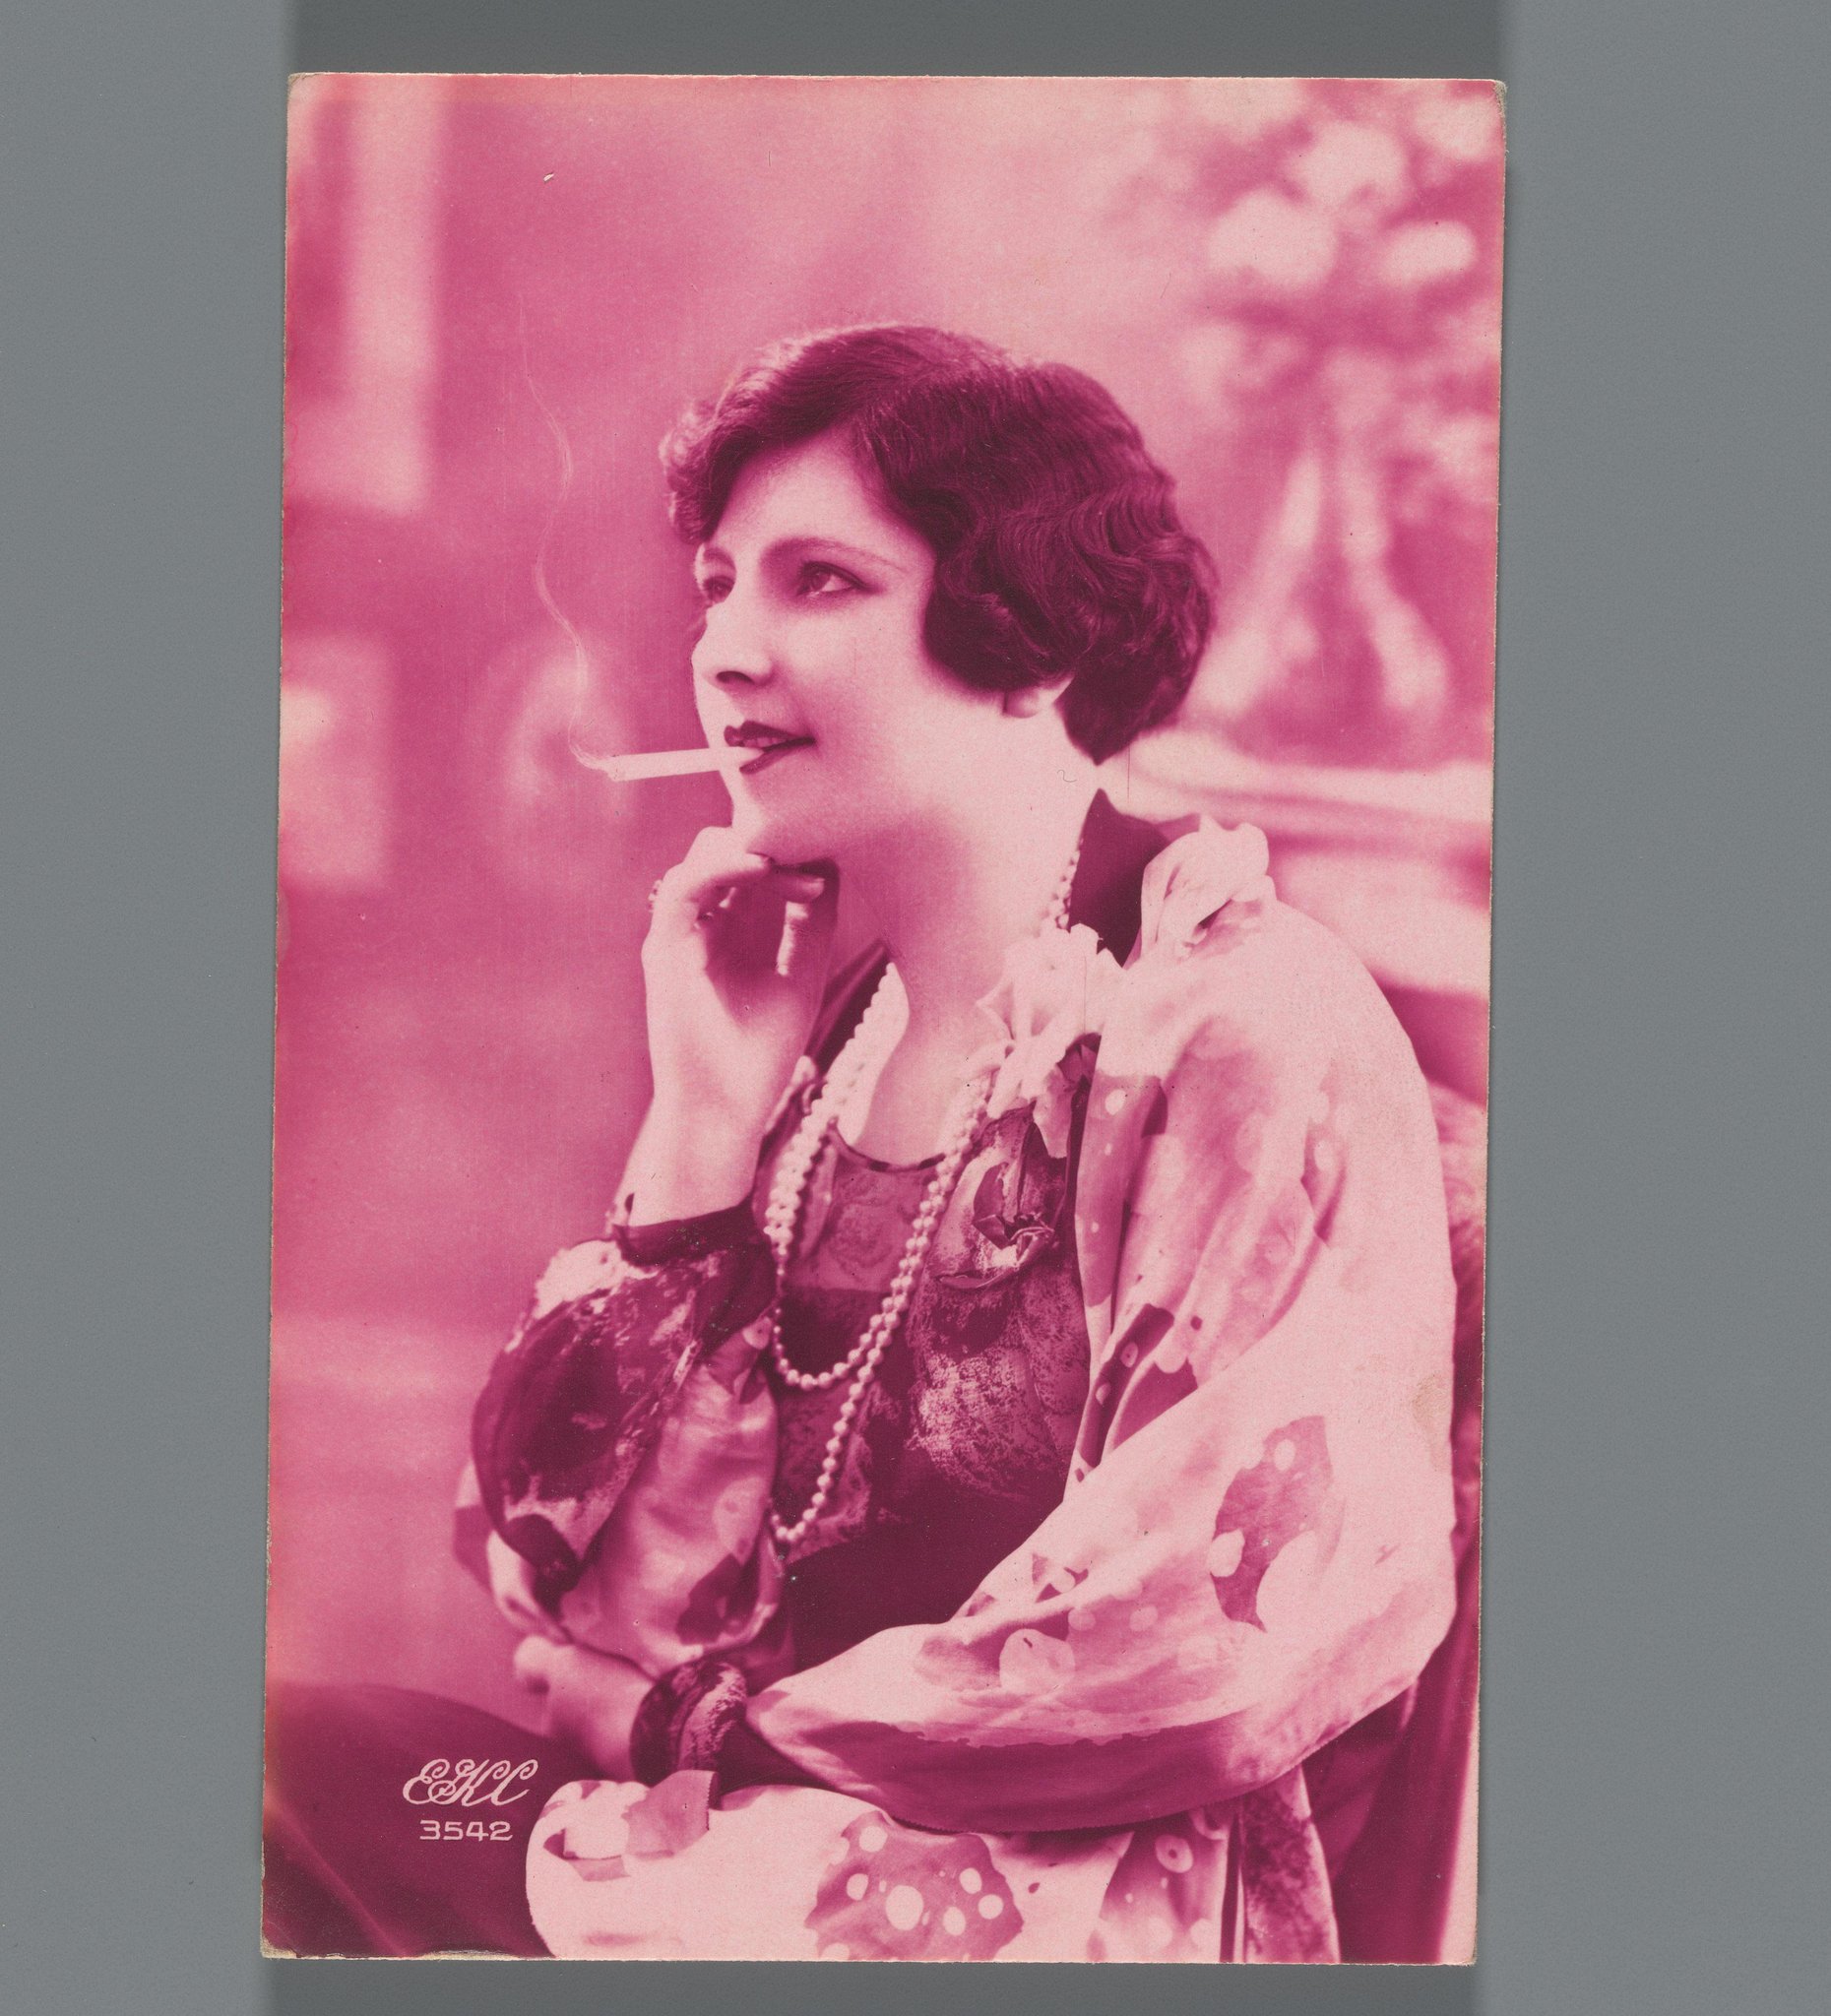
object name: ansichtkaart, prentbriefkaart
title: Portret van een onbekende rokende vrouw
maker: Anonymous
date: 1920-1940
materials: paper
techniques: gelatin silver print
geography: rochester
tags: anonymous historical person portrayed - bb - woman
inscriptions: number: ‘3542’